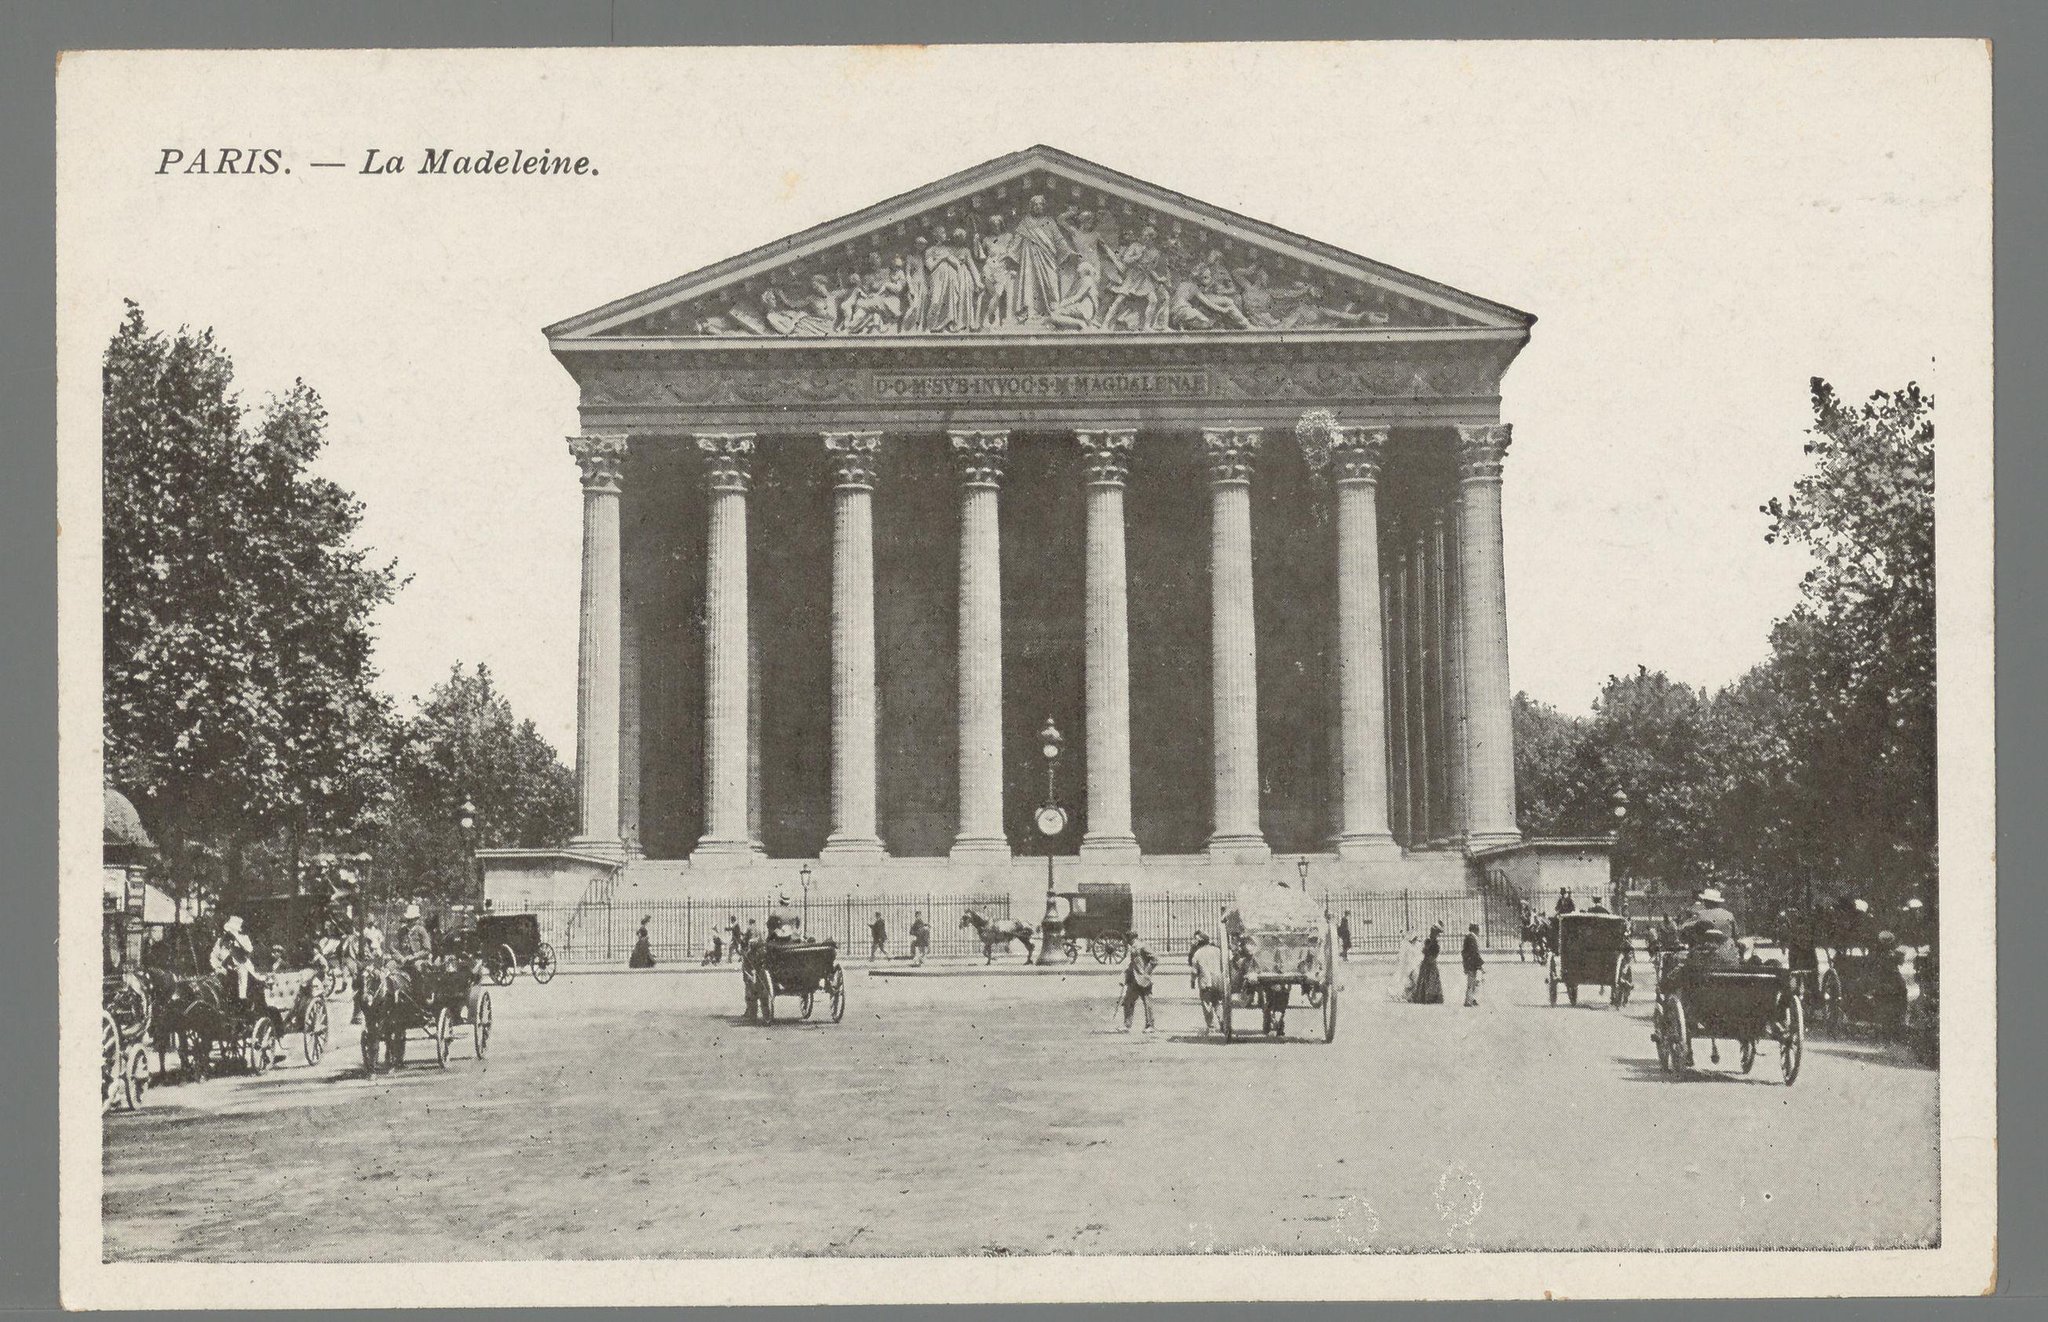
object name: ansichtkaart, prentbriefkaart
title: Paris. La Madeleine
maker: Anonymous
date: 1904-1906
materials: cardboard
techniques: autotype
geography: paris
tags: four-wheeled, animal-drawn vehicle, e.g.: cab, carriage, coach, church (exterior), square, place, circus, etc. (+ city(-scape) with figures, staffage)